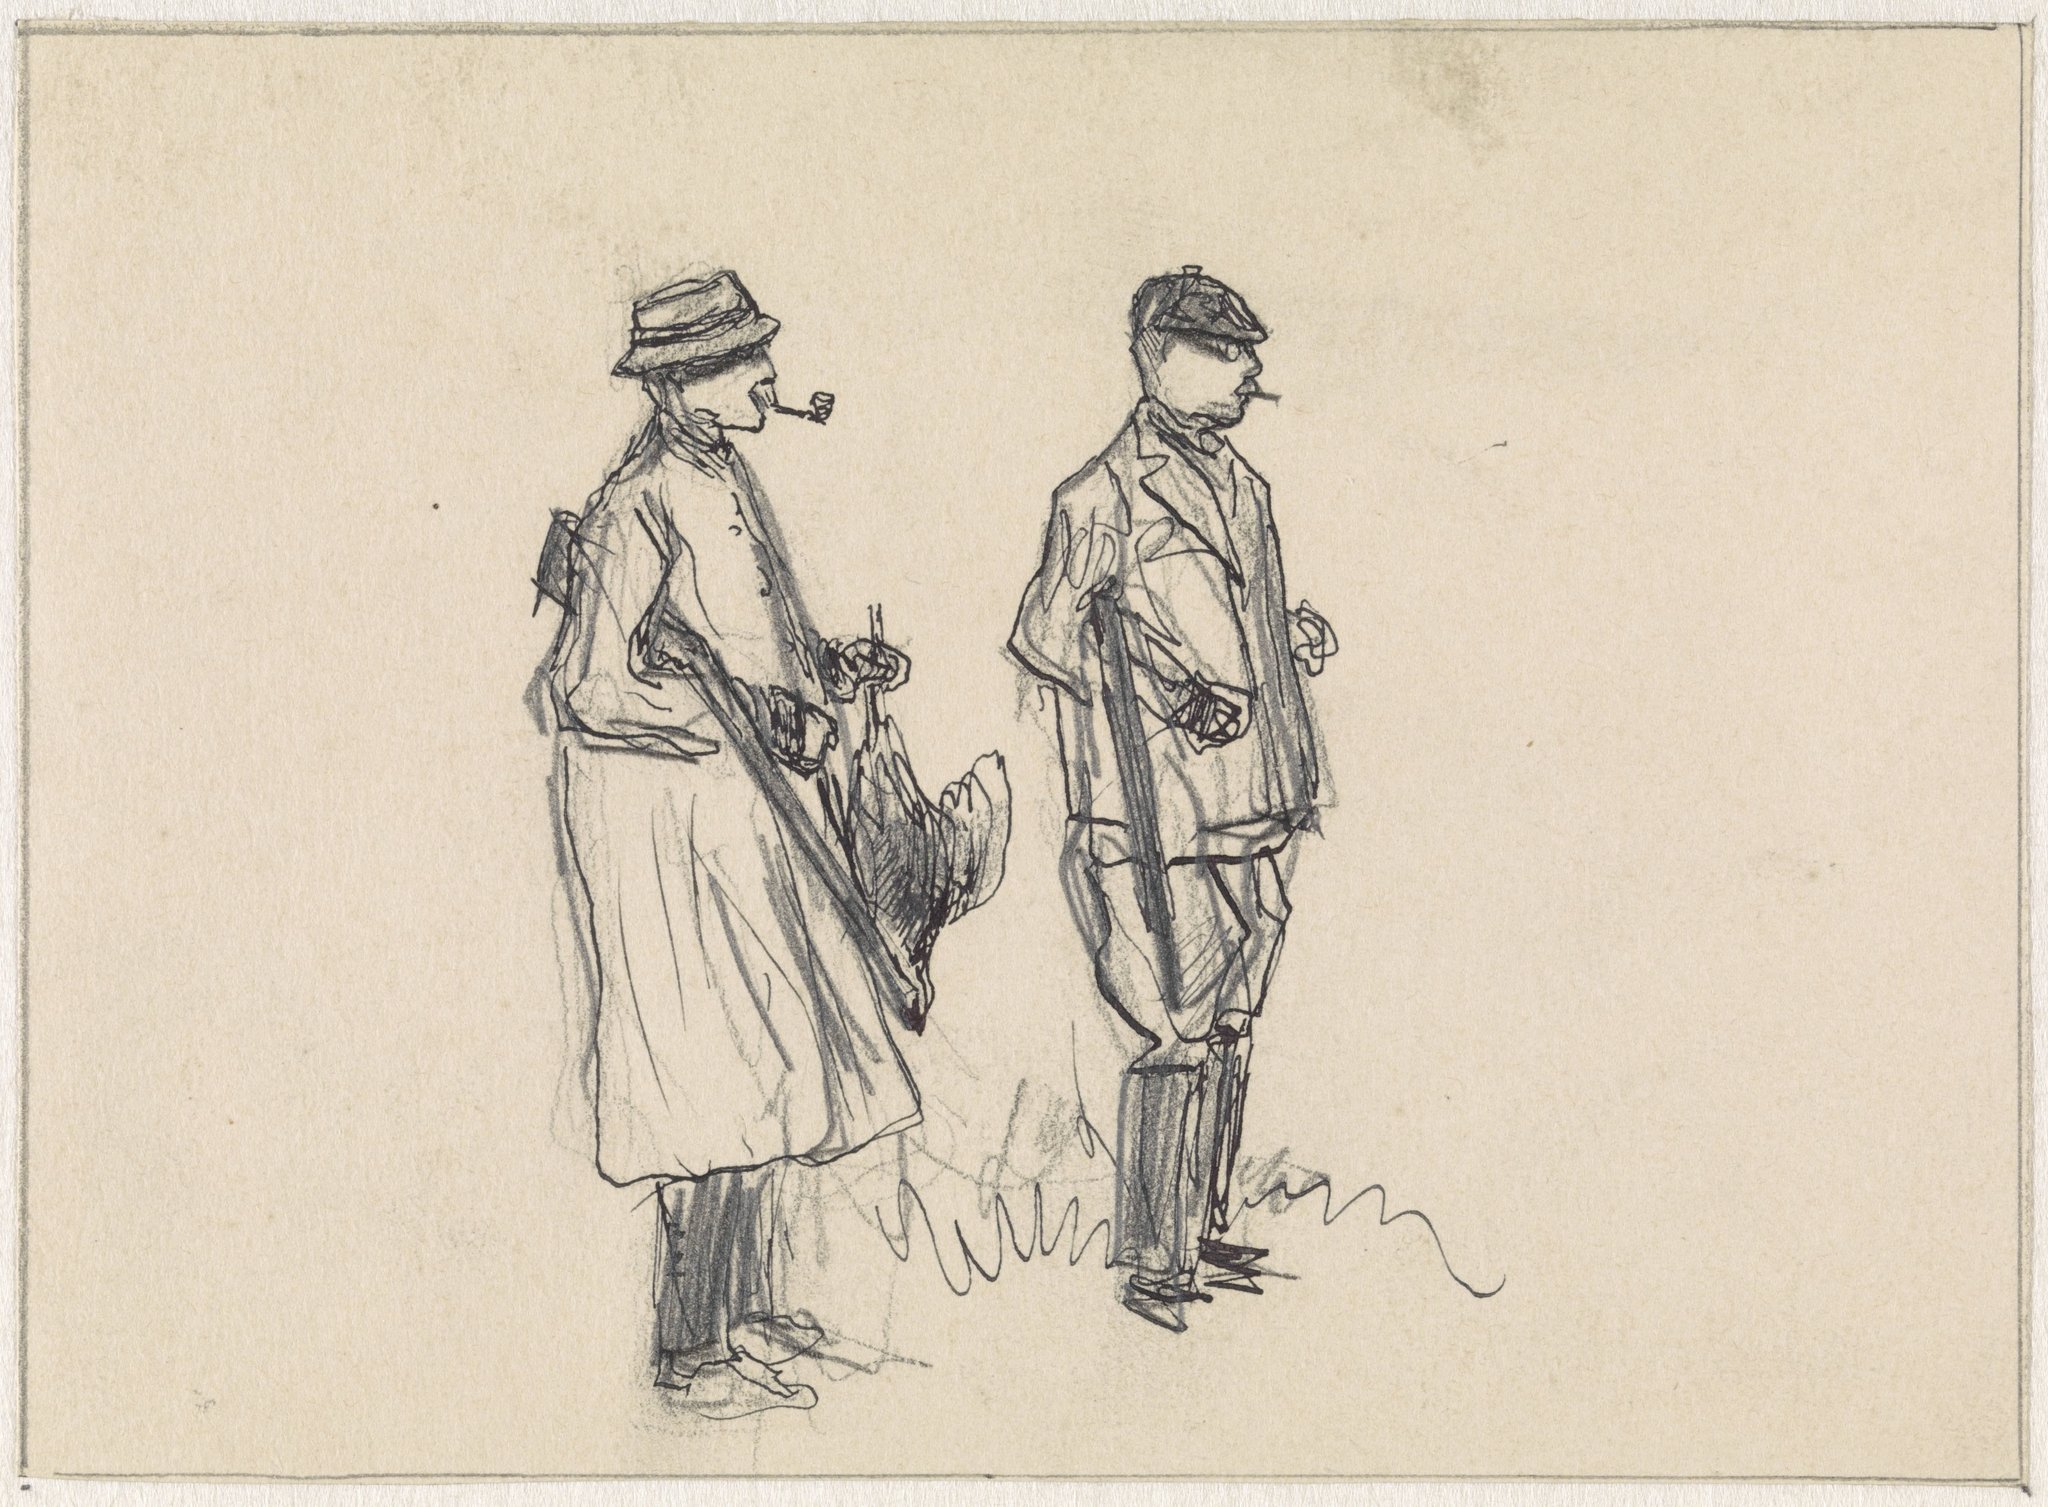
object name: drawing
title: Twee jagers, staand naar rechts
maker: jan van essen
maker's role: draughtsman, print maker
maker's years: 1854-1936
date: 1864-1936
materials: ink, paper, pencil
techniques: pen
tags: hunter